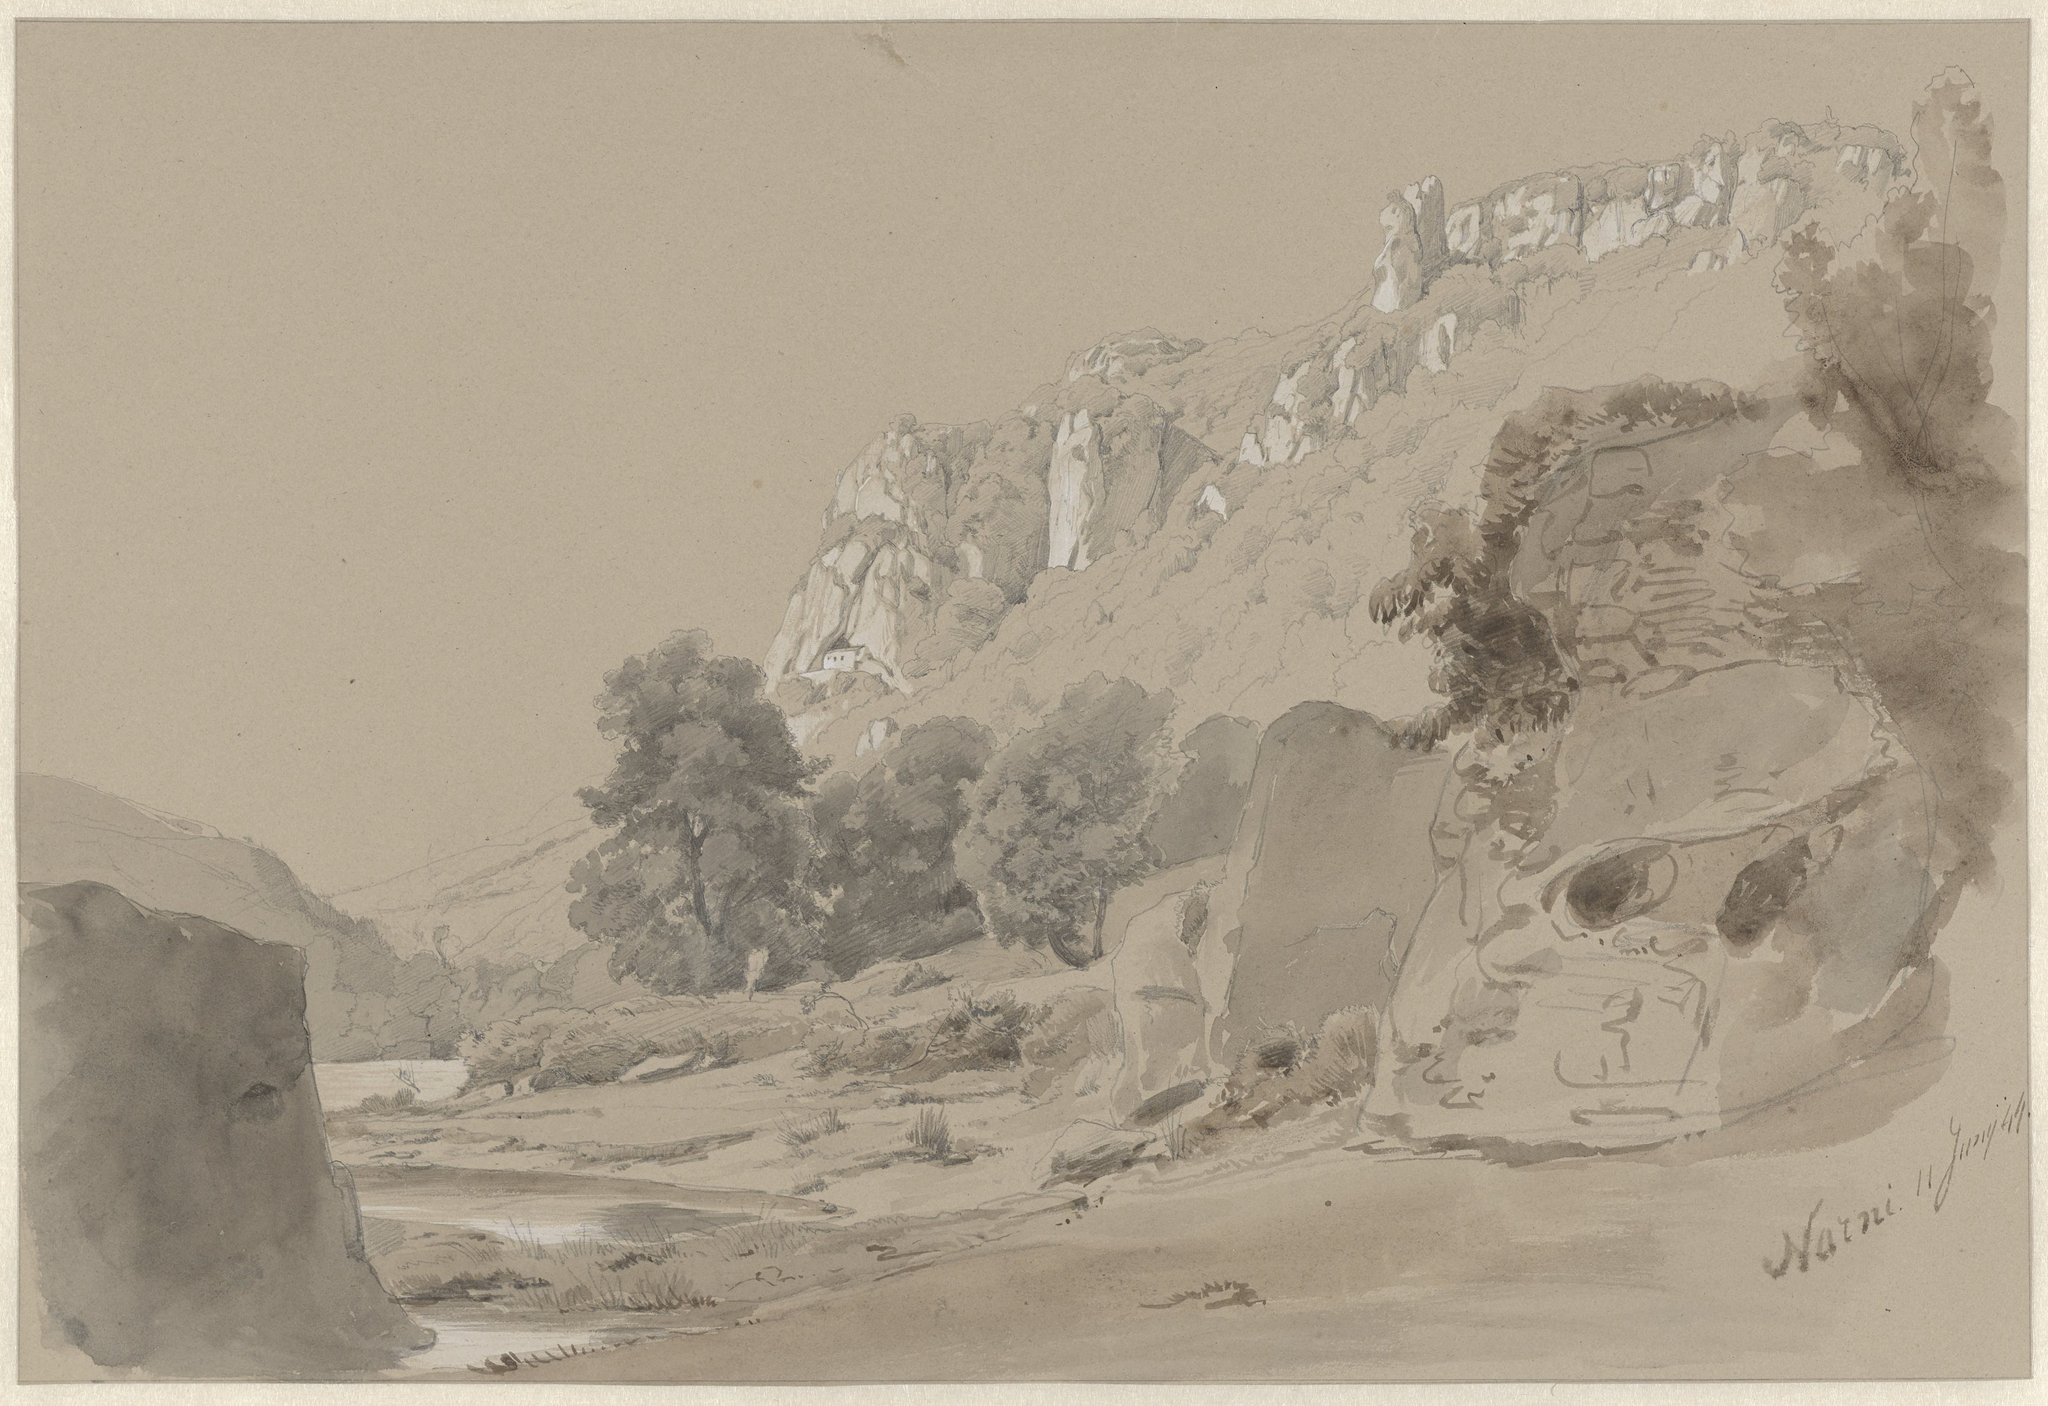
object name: drawing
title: The Nera River near Narni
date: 1844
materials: chalk, paint, paper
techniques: brush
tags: rocks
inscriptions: date and inscription: ‘Narni 11 Junij 44.’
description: Dubourcq and his travelling companion, the painter Willem Bodeman, spent the winter in Rome. Dubourcq later wrote to a colleague ‘…for the ordinary traveller Rome is rather somber and sad, but for us it was a favourite place to be.’ The friends headed back north in the spring of 1844, making ‘a study tour’ of their journey. They stayed in Narni, a hilltop village in Umbria, for a few days in June.